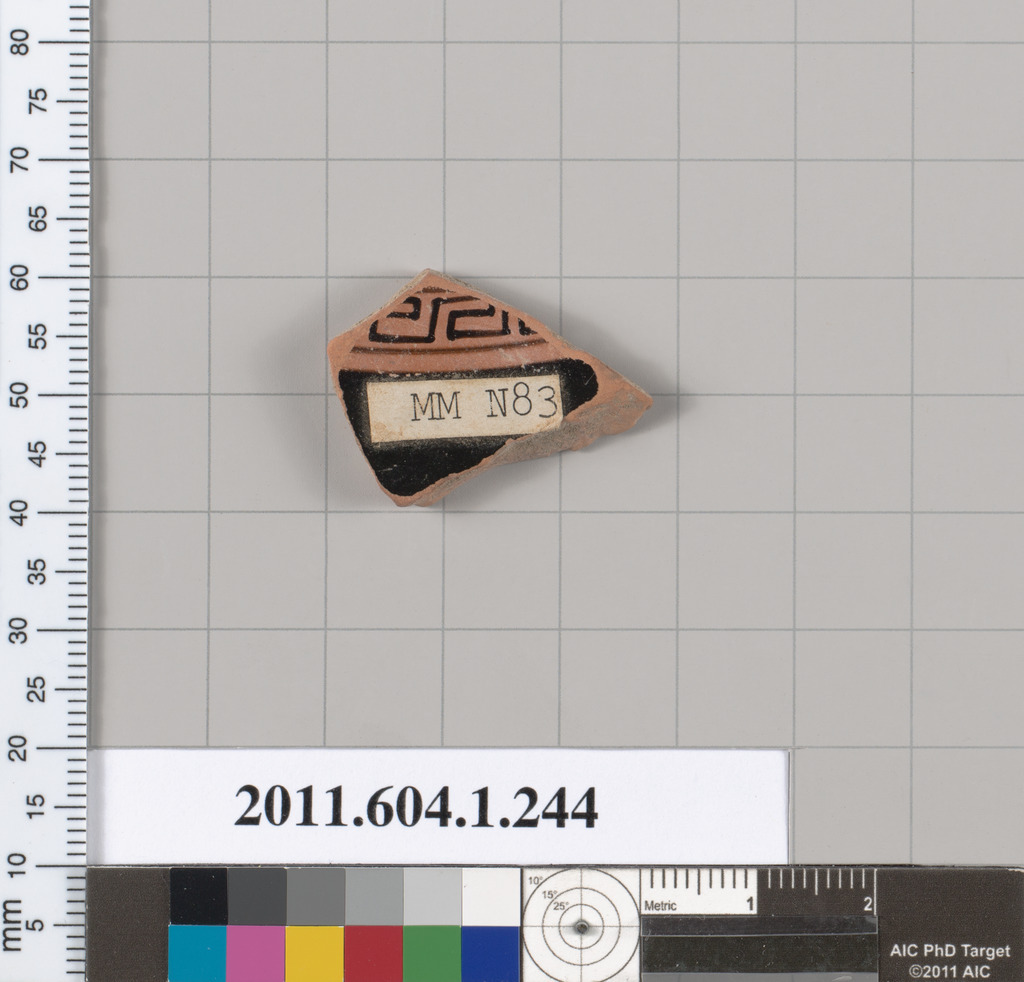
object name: kylix fragment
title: Terracotta fragment of a kylix (drinking cup)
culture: greek, attic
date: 475-451 BCE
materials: terracotta